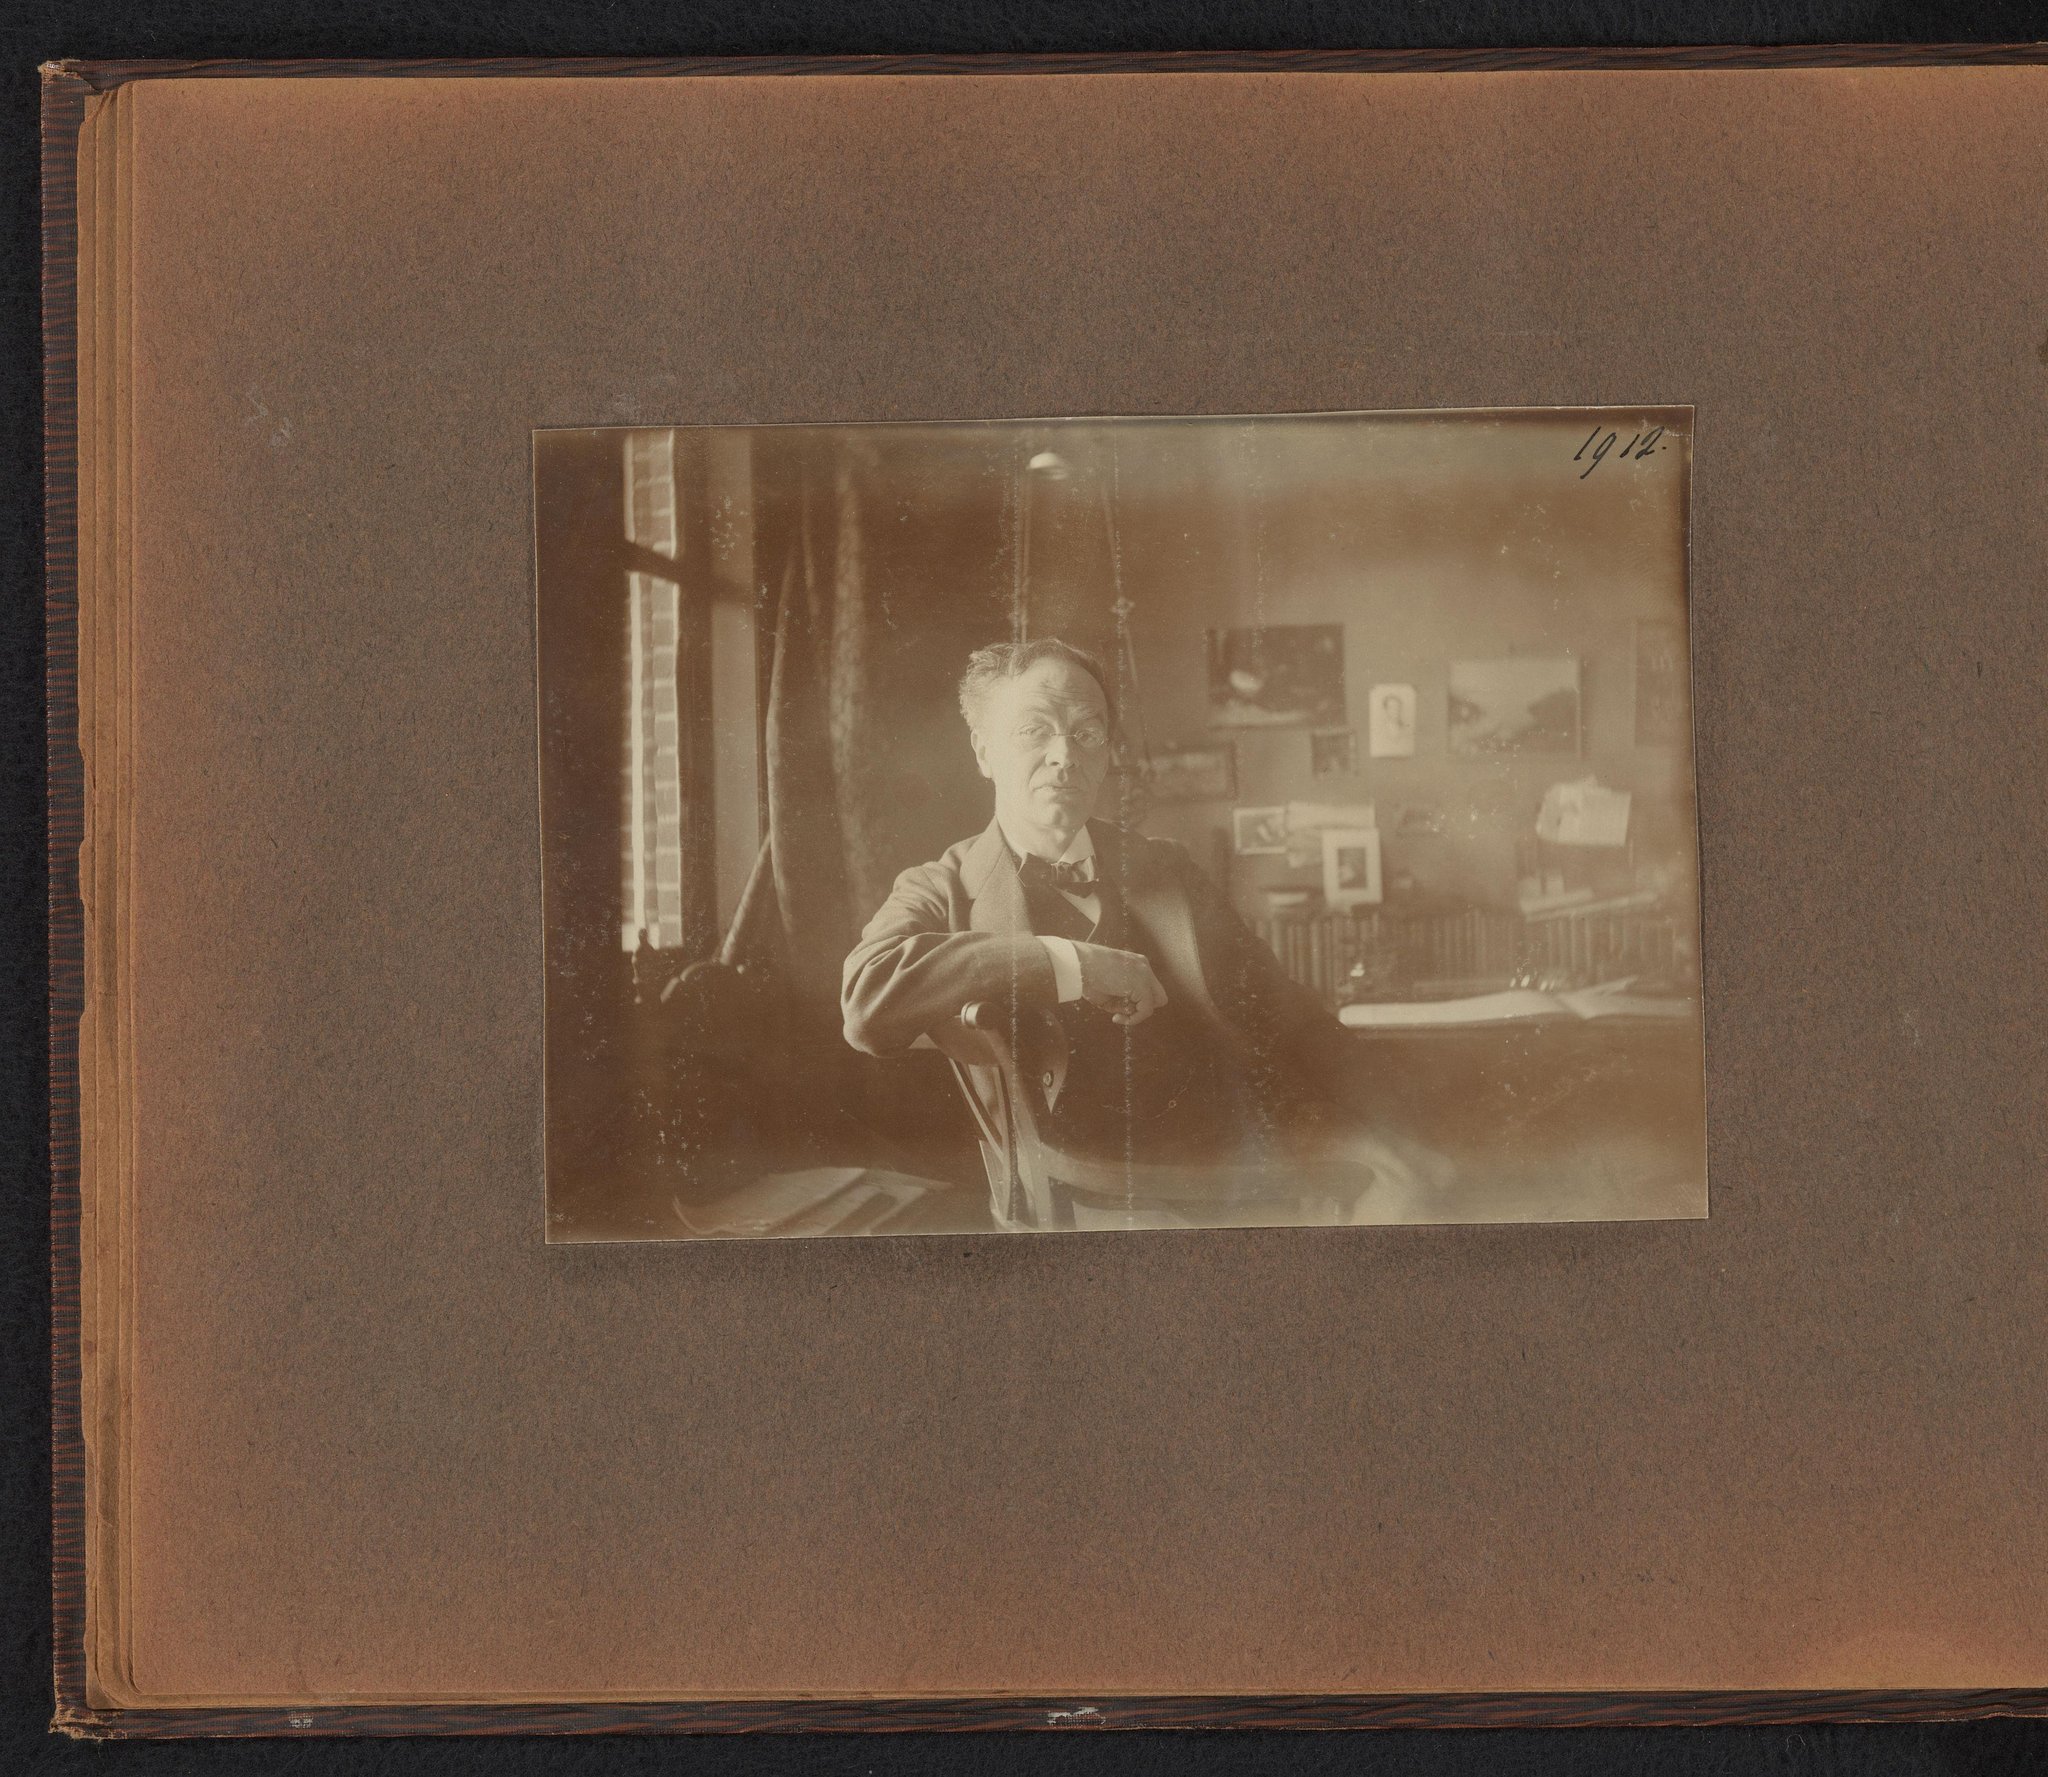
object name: photograph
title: Bladzijde uit het fotoalbum van de familie Diepenbrock met foto van Alphons Diepenbrock in interieur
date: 1912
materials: cardboard, photographic support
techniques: photography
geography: netherlands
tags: alphons diepenbrock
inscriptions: date: ‘1912.’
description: Bruin albumblad 6 van familiealbum van Alphons Diepenbrock.